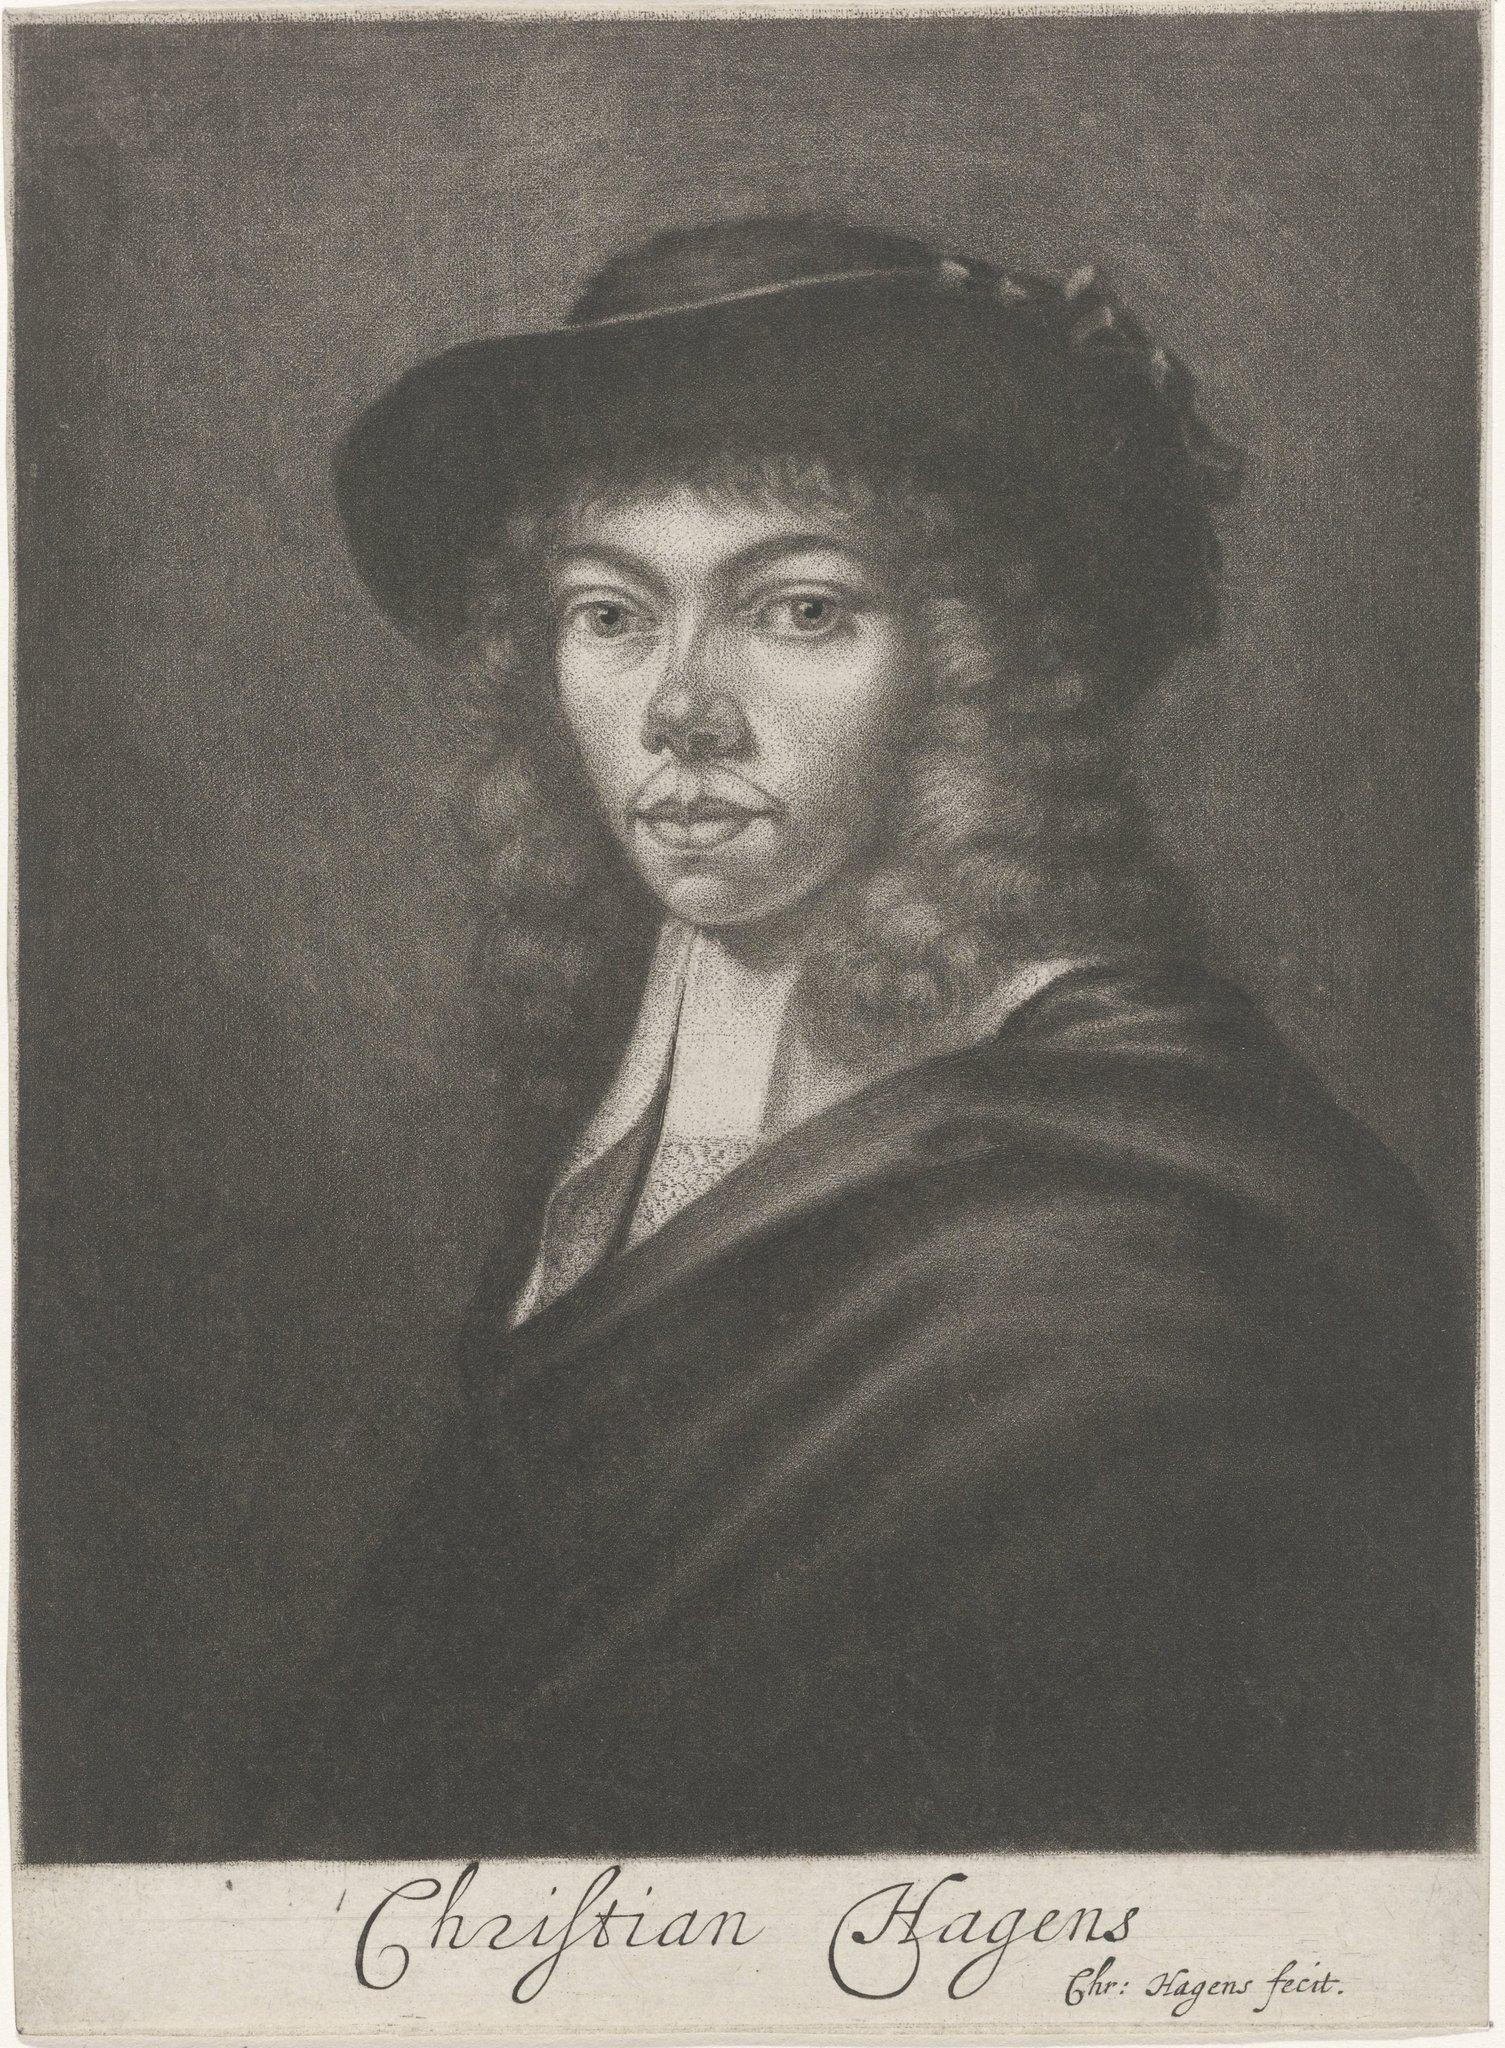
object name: print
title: Zelfportret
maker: christiaan hagen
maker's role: draughtsman, print maker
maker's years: 1635-1707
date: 1663-1695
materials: paper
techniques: engraving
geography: amsterdam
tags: print maker, draughtsman, christiaan hagen, portrait, self-portrait of artist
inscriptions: collector's mark: Lugt 2228